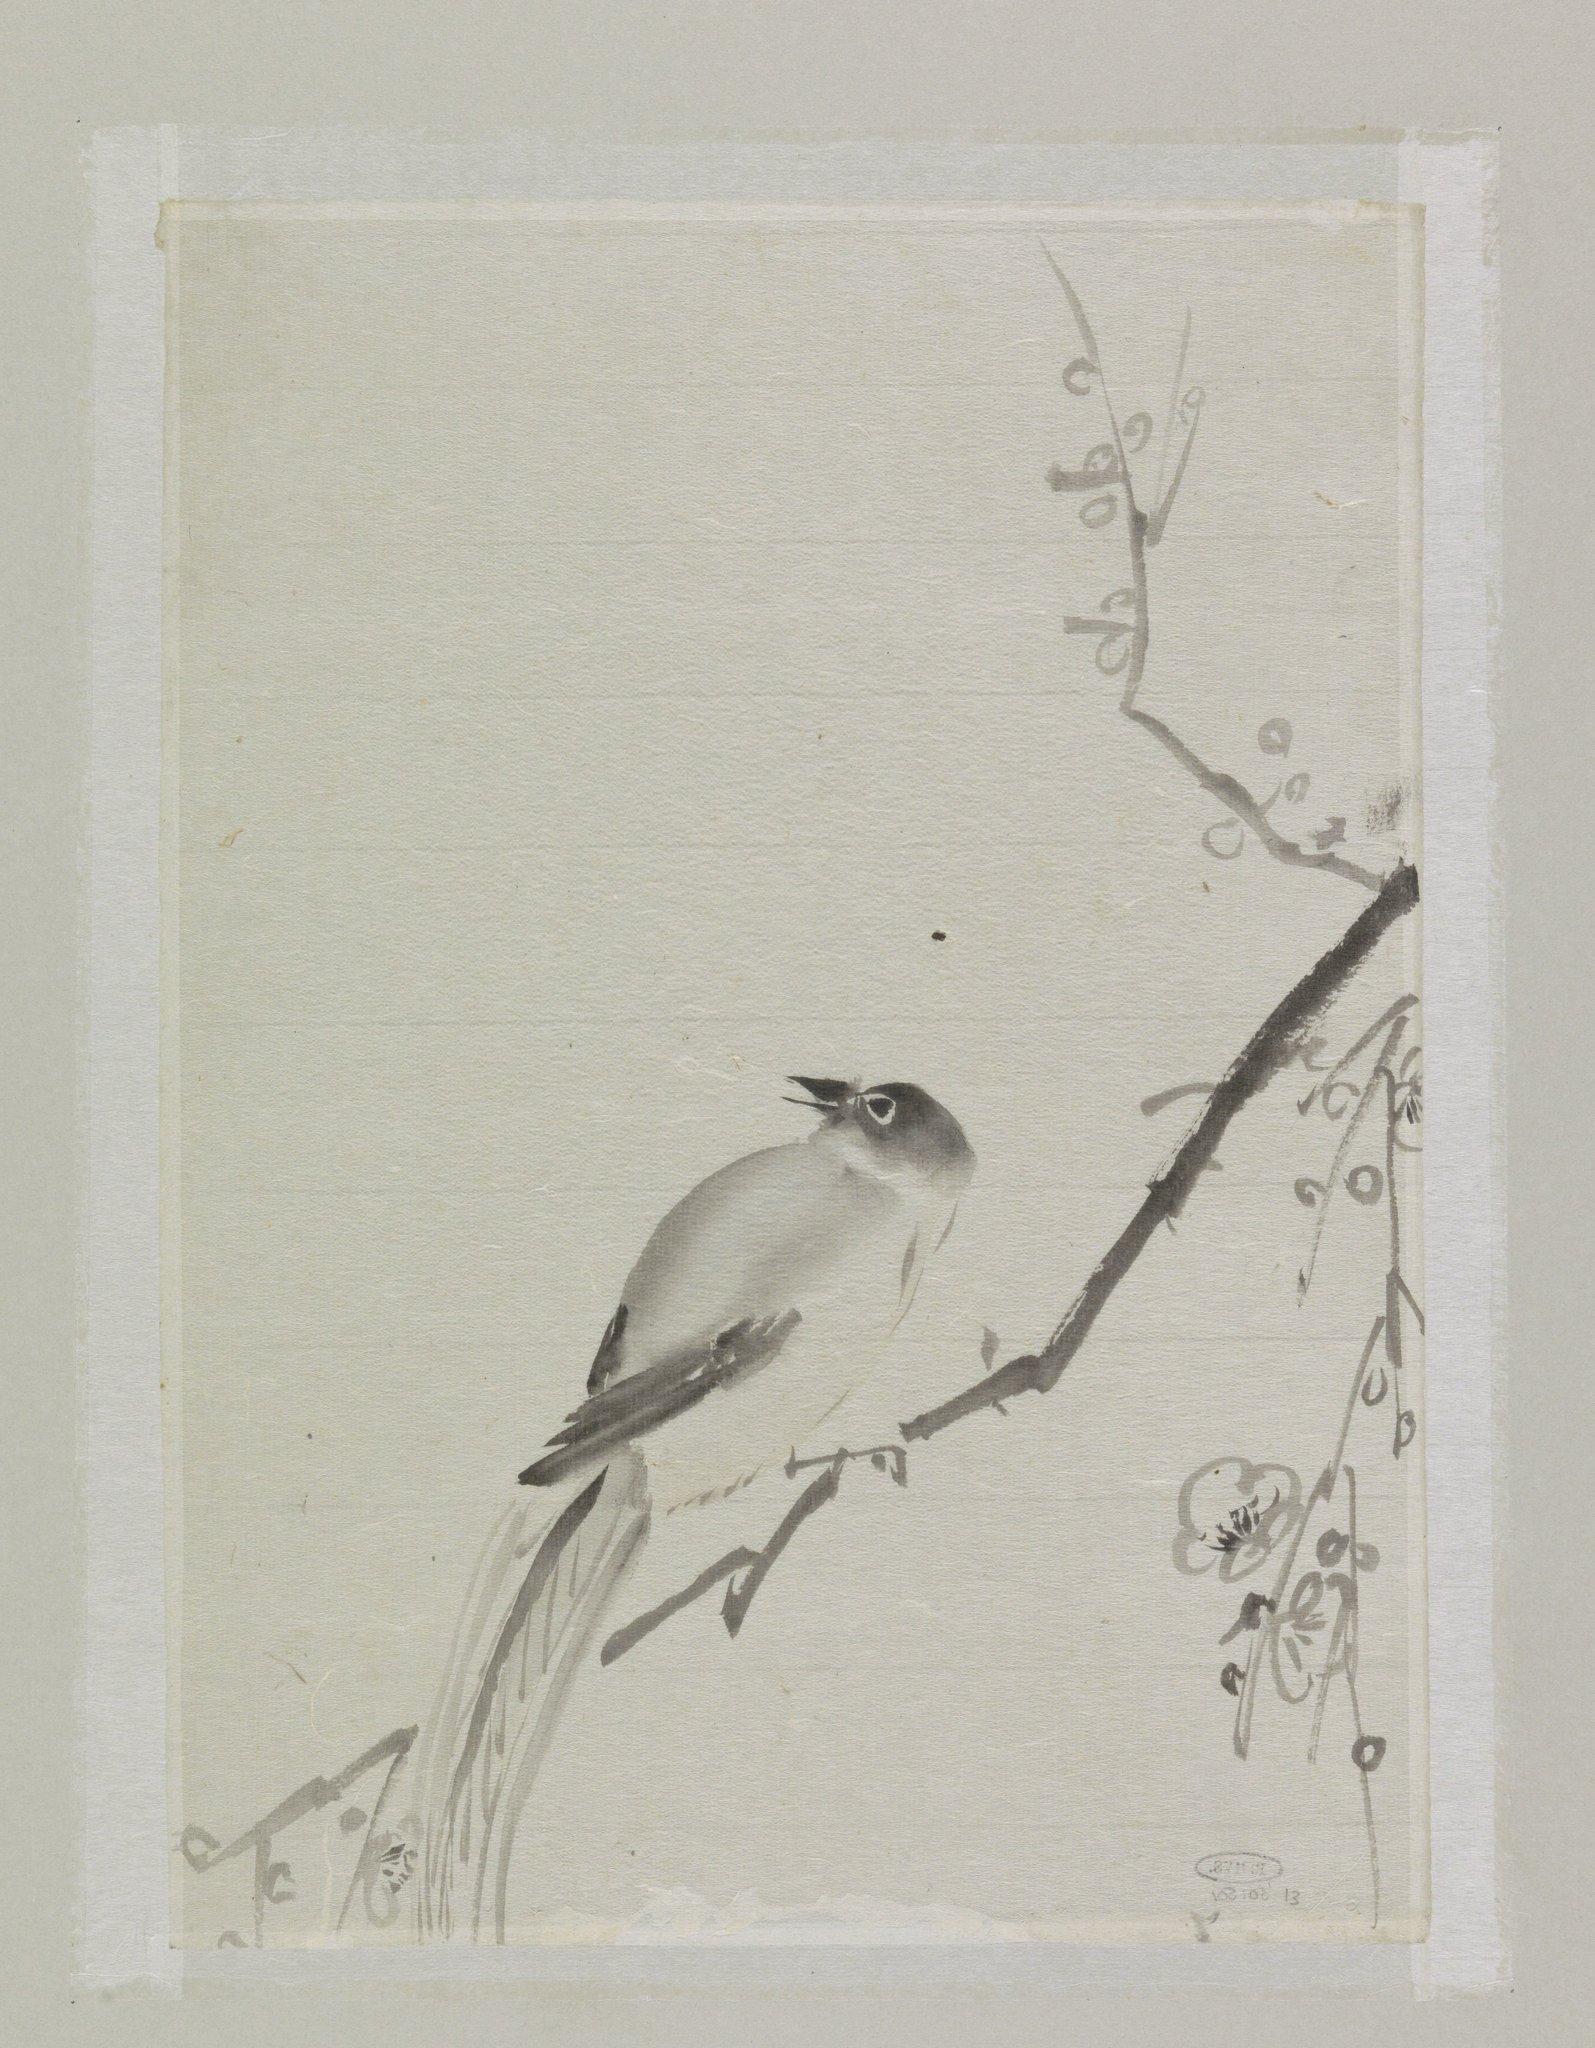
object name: drawing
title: Vogel op een tak van een kersenboom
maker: ishikawa kazan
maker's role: draughtsman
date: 1800-1900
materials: paper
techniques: brush